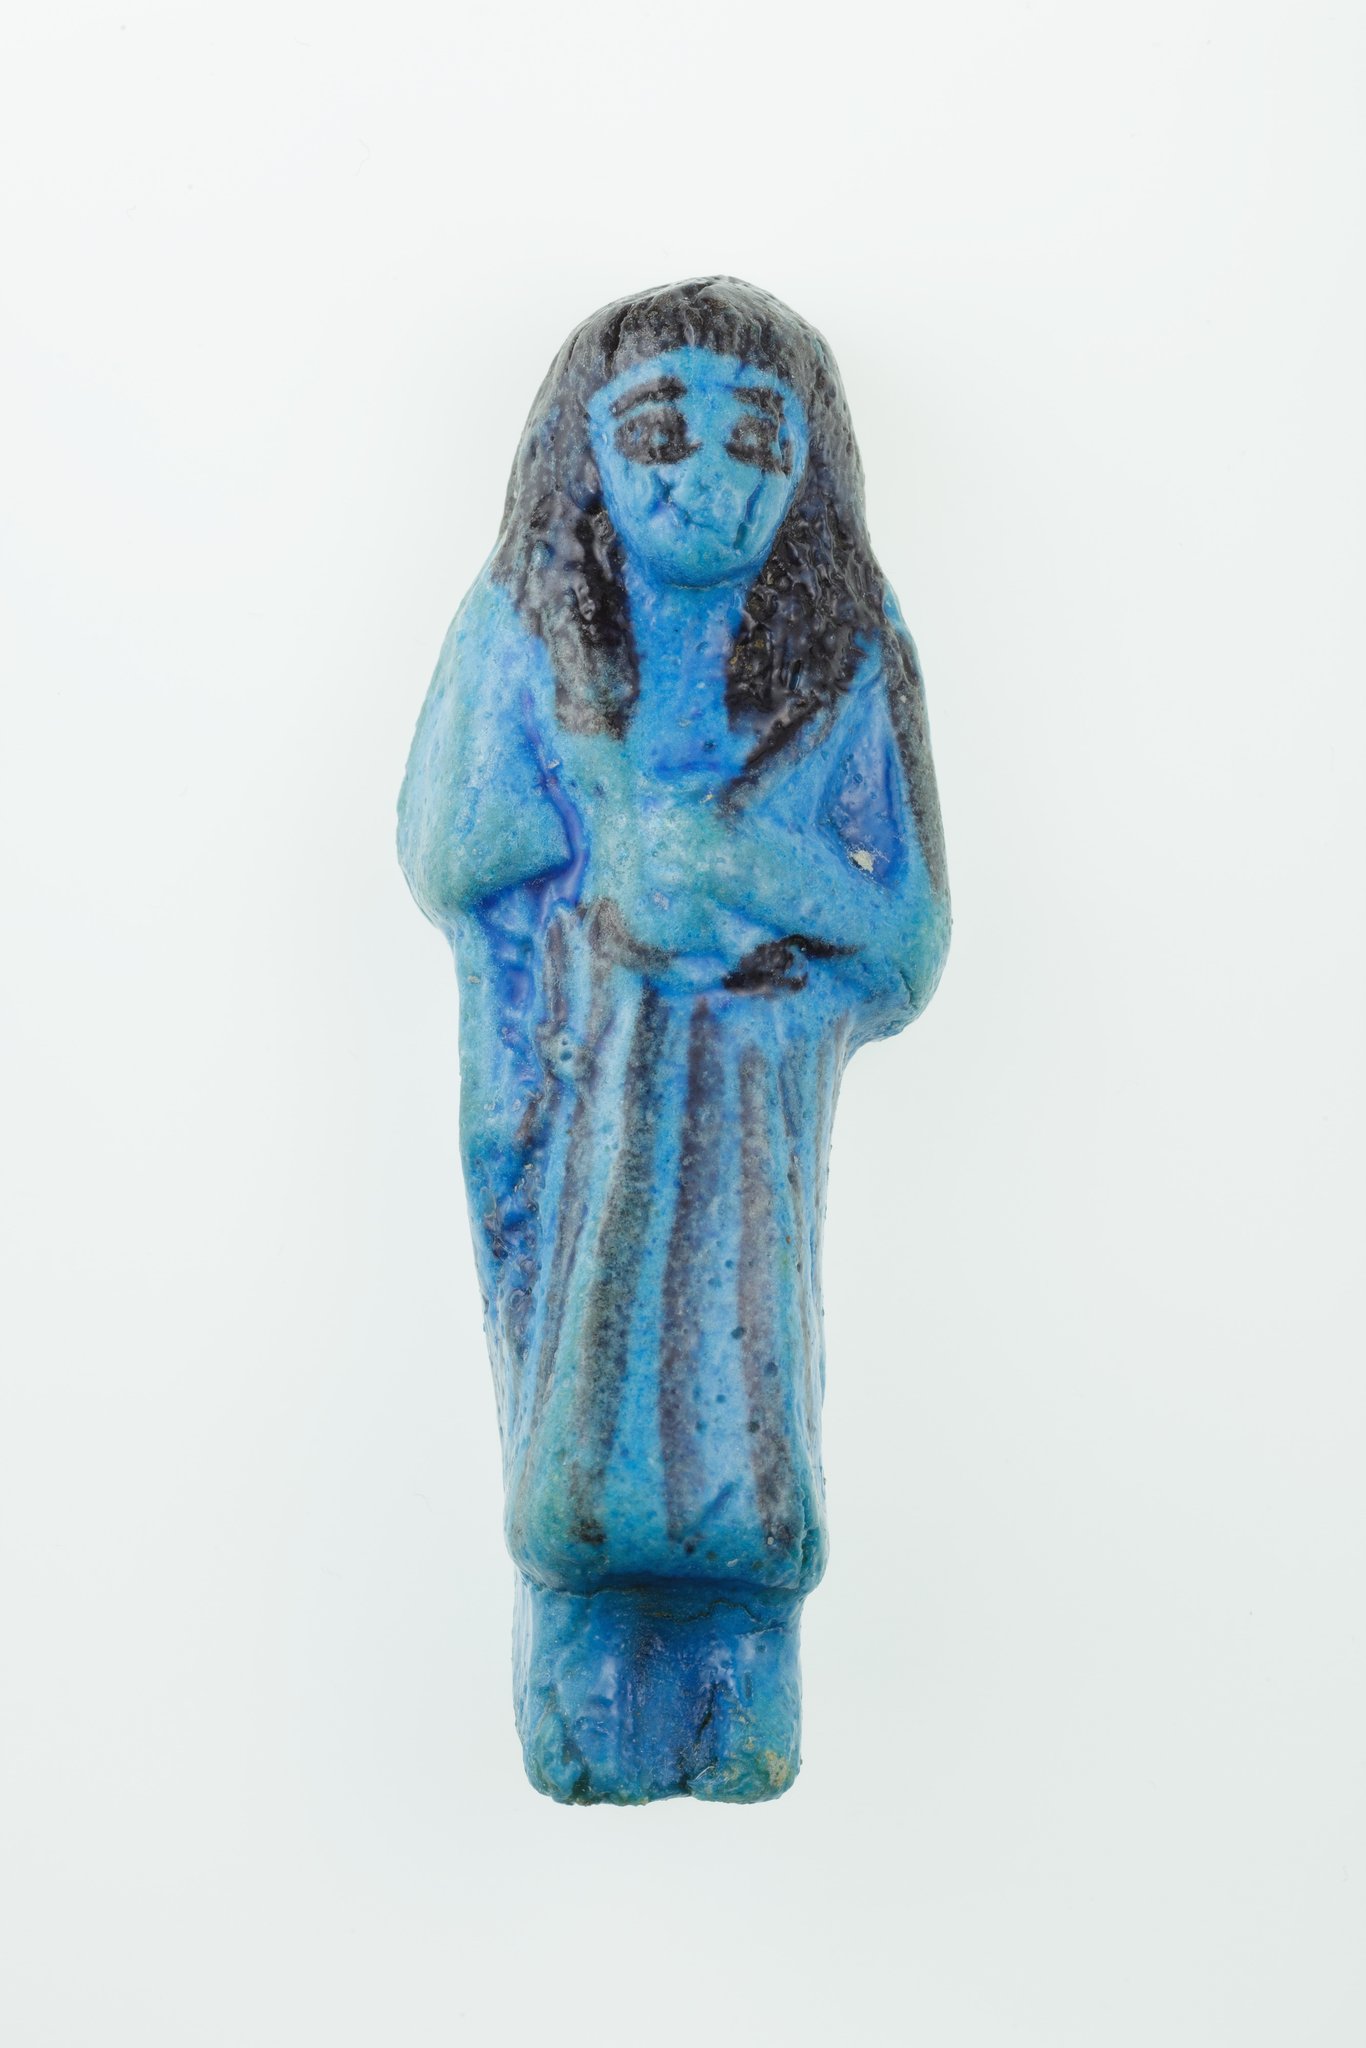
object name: shabti, overseer, nauny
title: Overseer Shabti of Nauny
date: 1050 BCE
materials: faience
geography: egypt